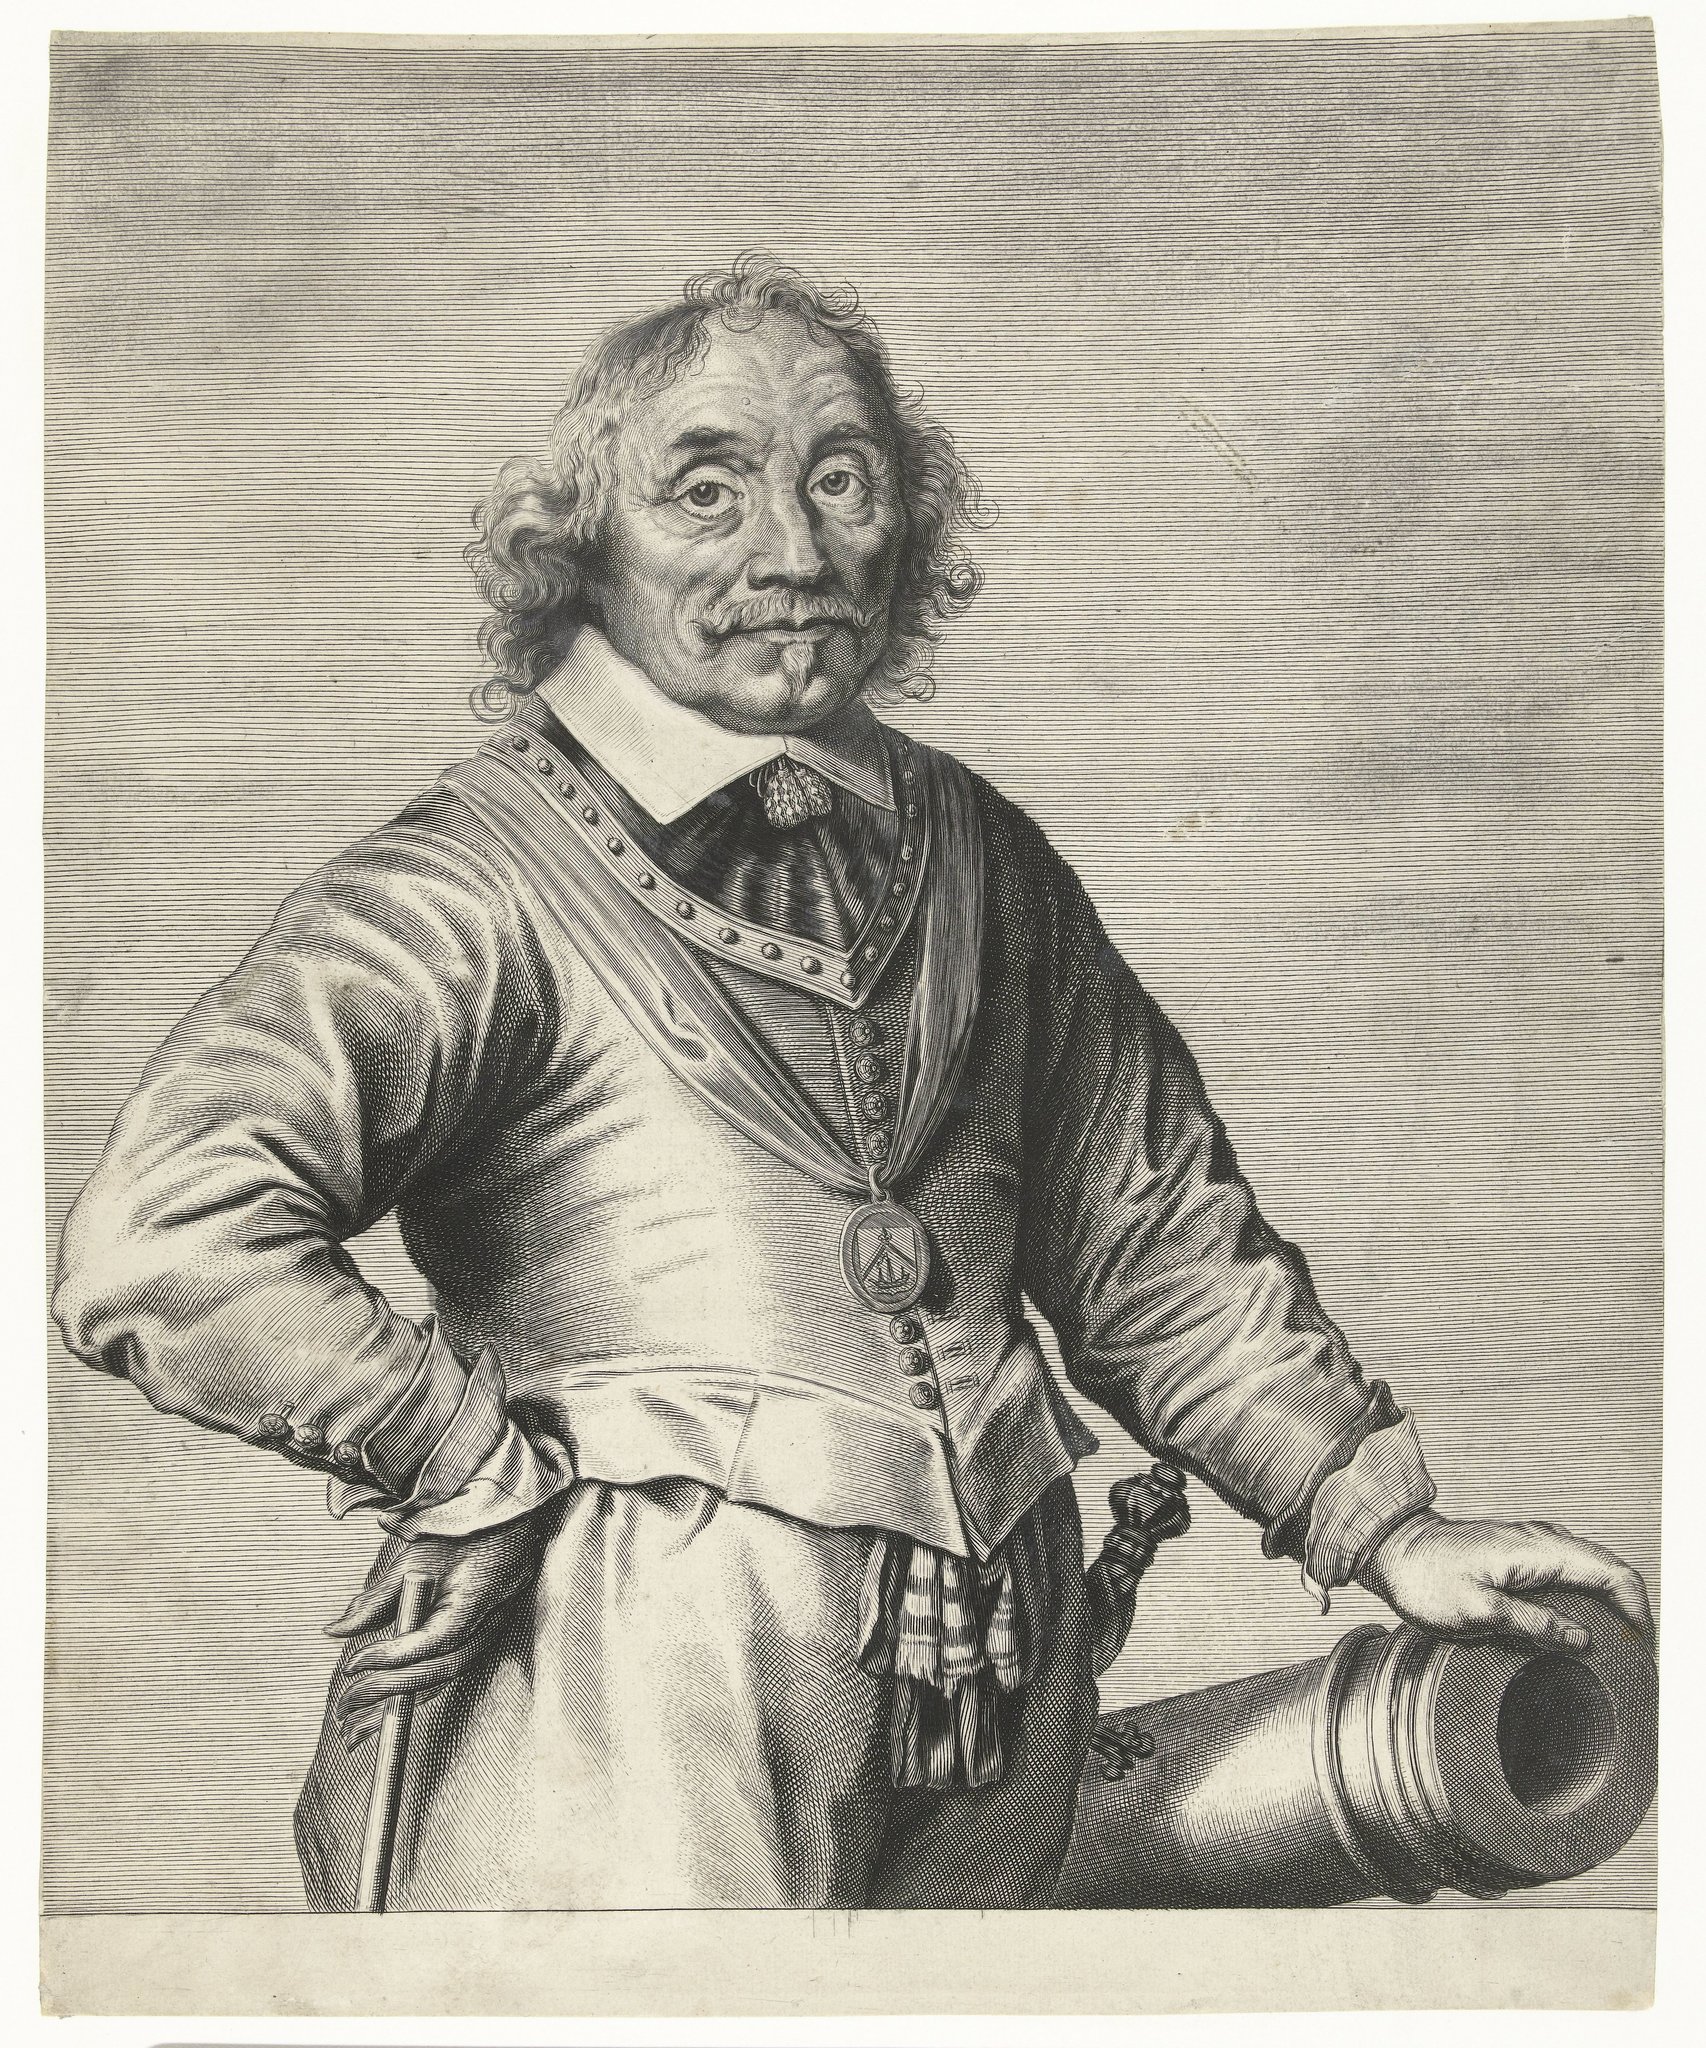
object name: print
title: Portret van Maarten Harpertszoon Tromp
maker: cornelis van dalen (ii)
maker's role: draughtsman, print maker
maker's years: 1638-1664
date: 1648-1664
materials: paper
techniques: engraving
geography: amsterdam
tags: brielle, maarten harpertszoon tromp, historical persons, commander-in-chief, admiral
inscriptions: collector's mark: Lugt 2228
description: Prent naar schilderij van Jan Lievens. Er zijn meer staten en bovendien kopieën van het portret bekend dan bij Hollstein vermeld worden.